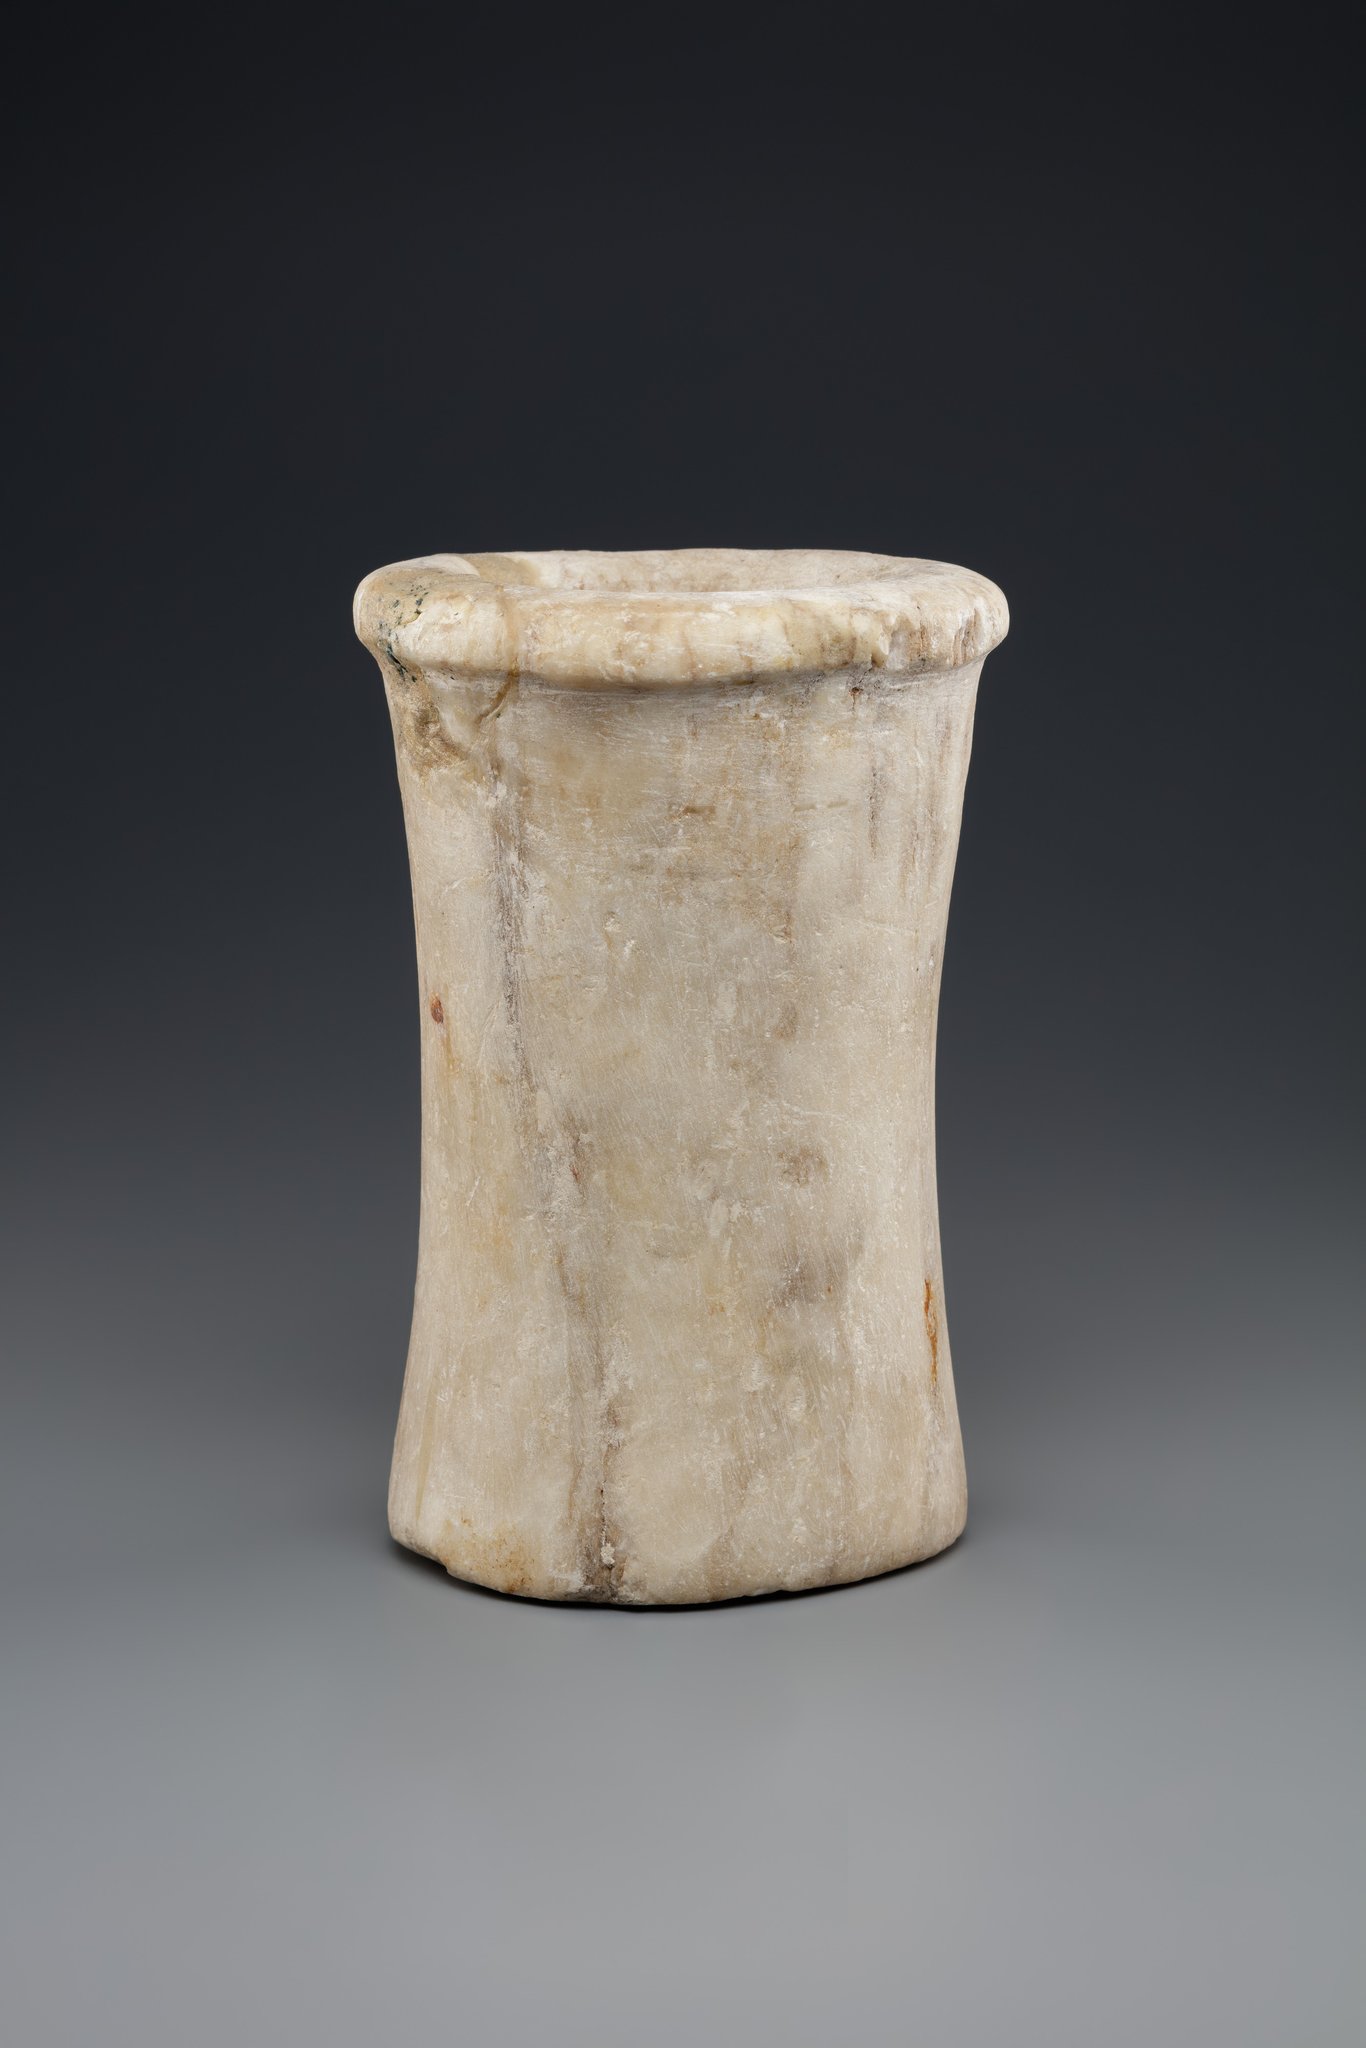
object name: jar, cylindrical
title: Cylinder jar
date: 3100-2649 BCE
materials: alabaster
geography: egypt